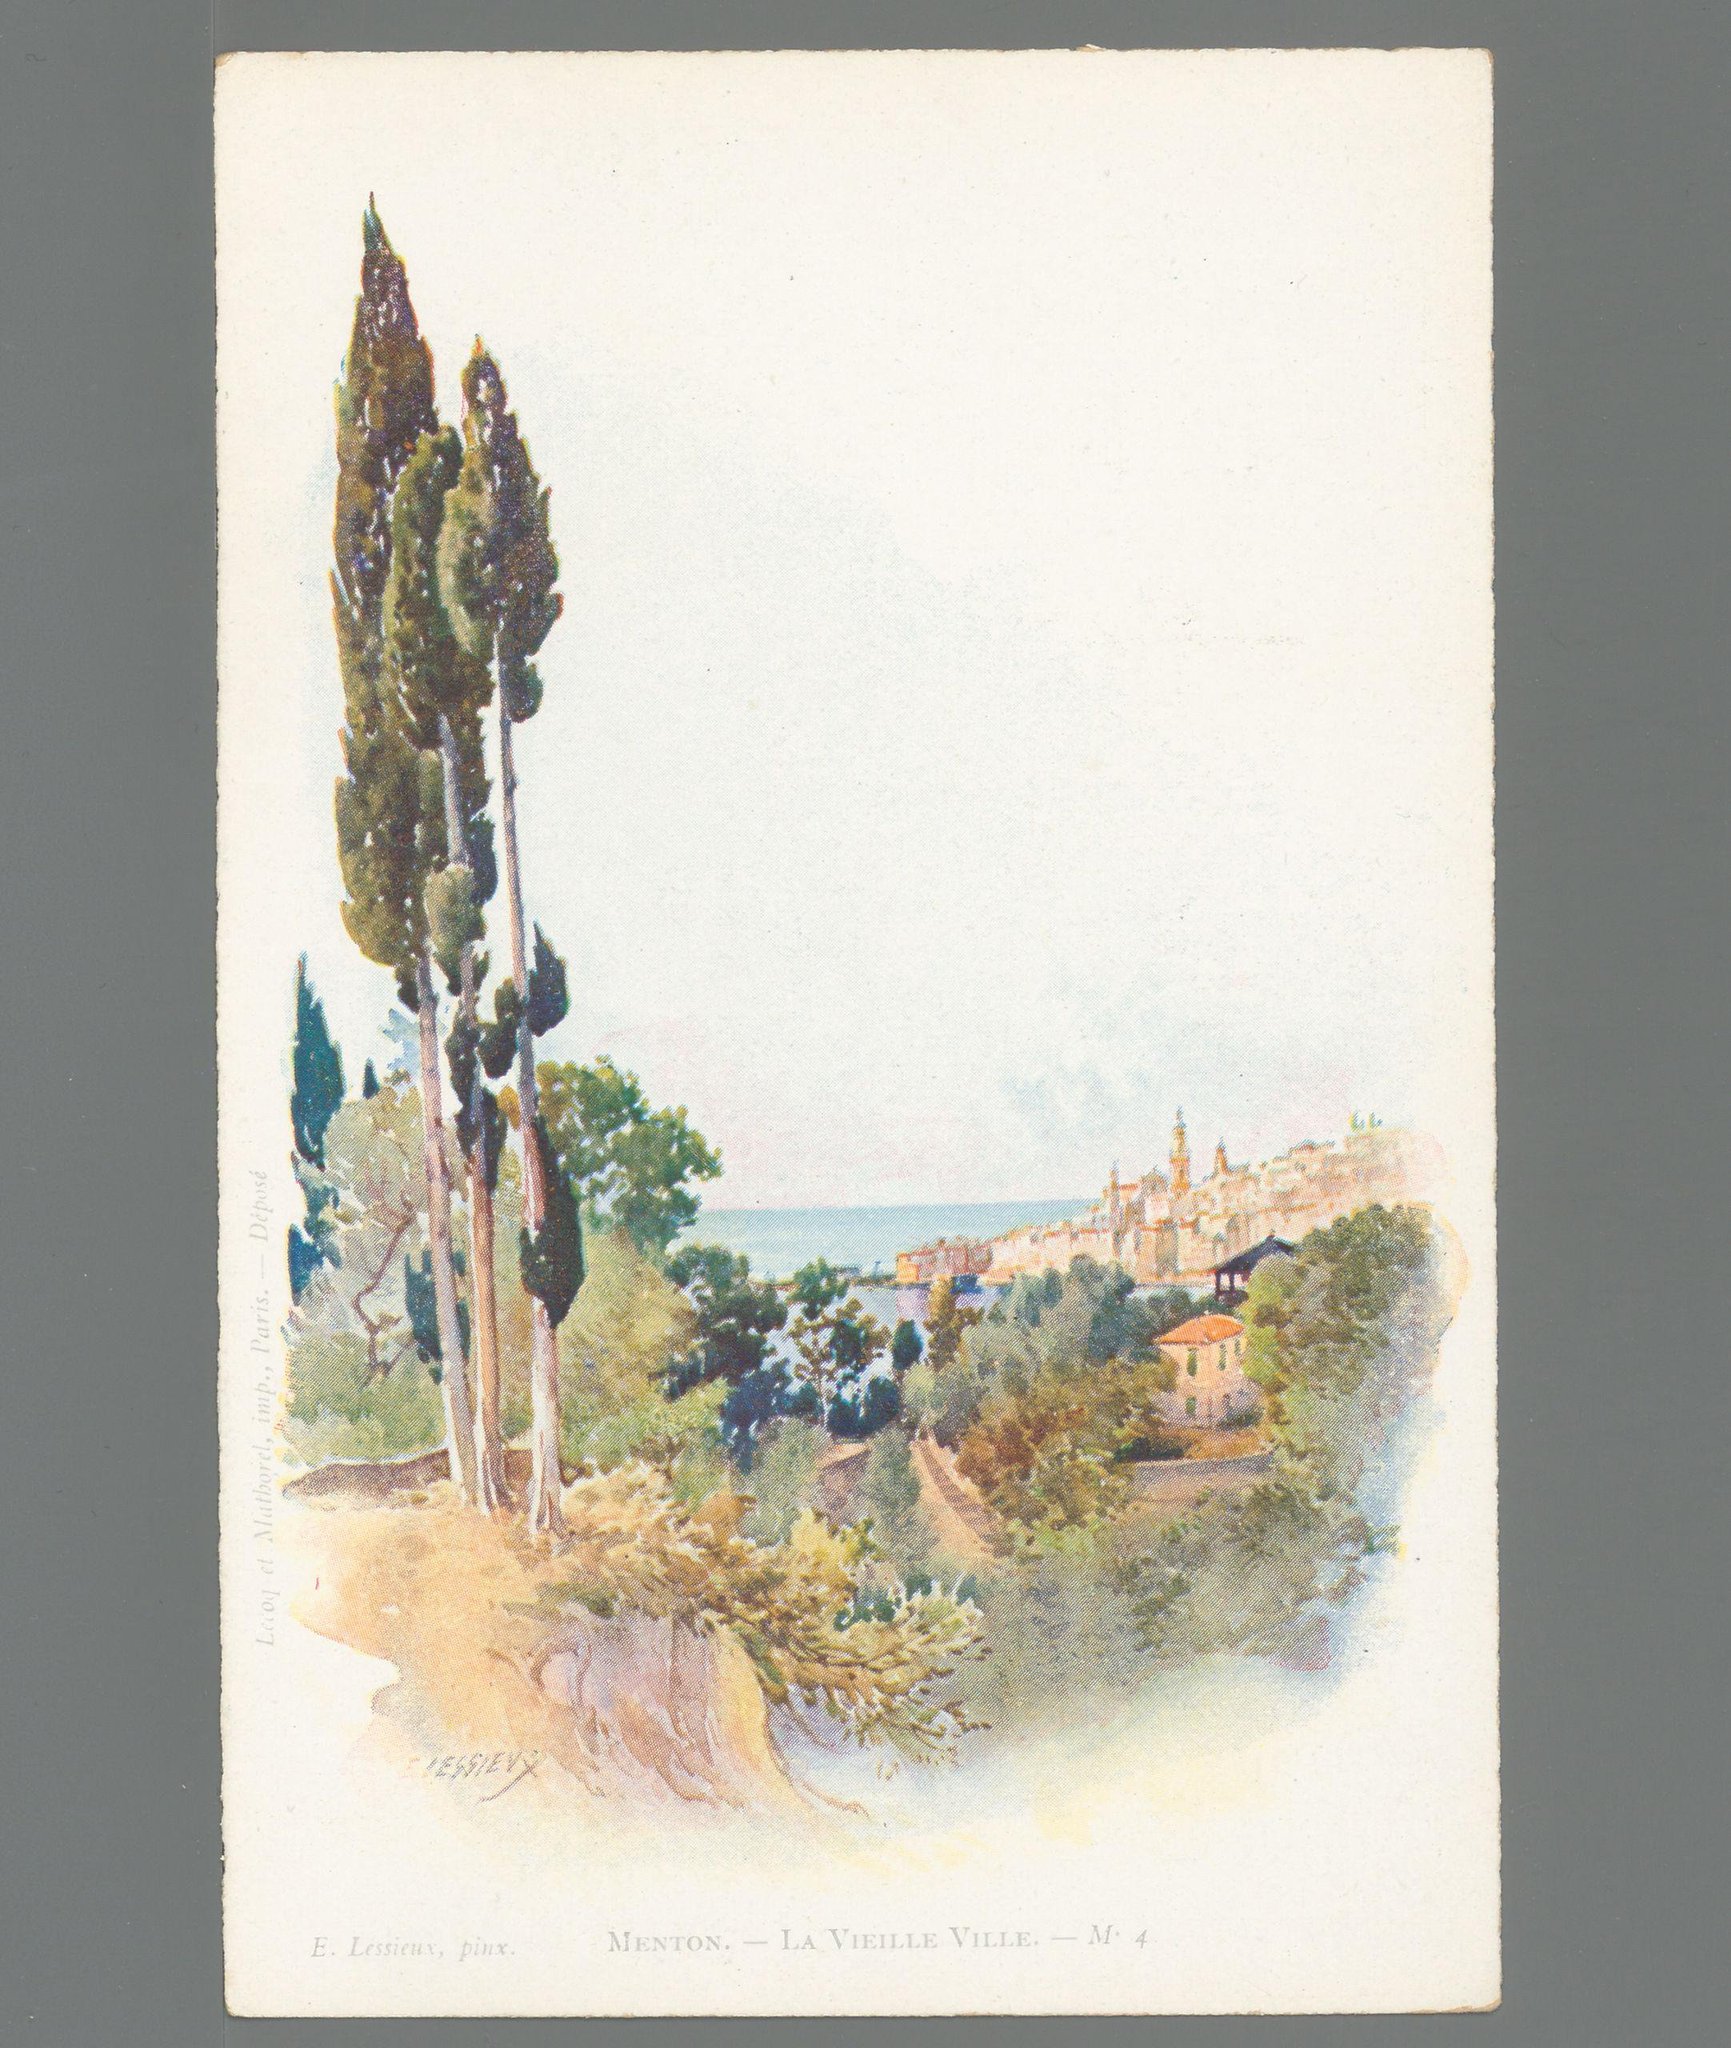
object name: photomechanical print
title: Menton, Monaco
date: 1892-1904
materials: cardboard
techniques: writing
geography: paris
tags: coast, prospect of city, town panorama, silhouette of city